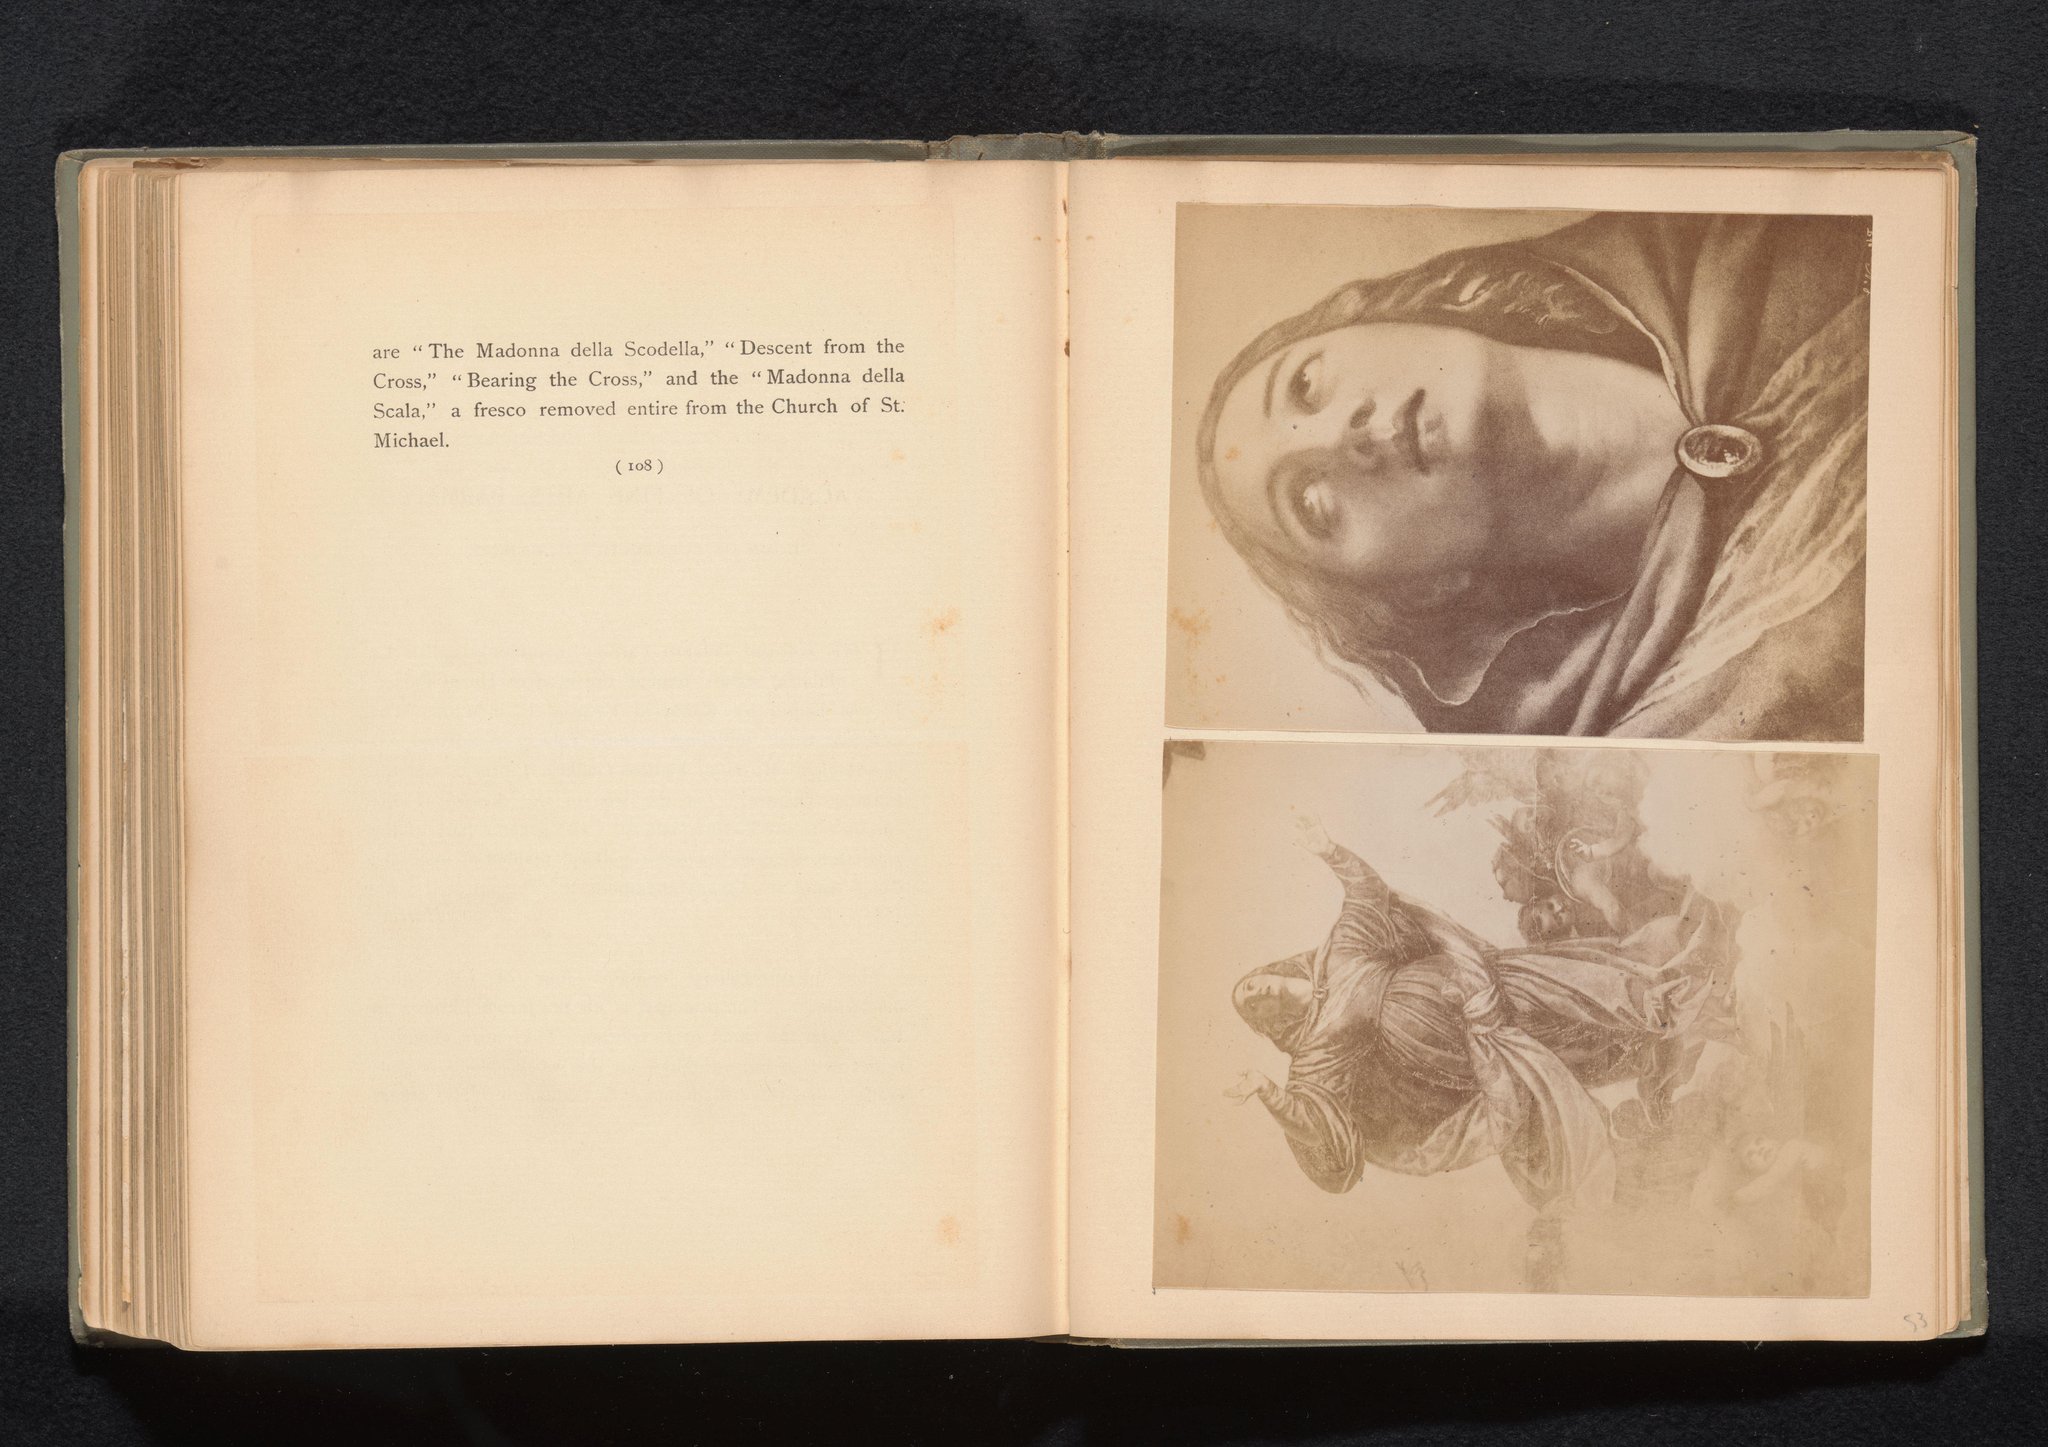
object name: page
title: Twee fotoreproducties van een schilderij, voorstellende de hemelvaart van Maria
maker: Anonymous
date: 1882-1887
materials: photographic support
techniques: albumen print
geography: basilica di santa maria gloriosa dei frari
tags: the assumption of mary ('assumptio corporis'): she is borne into heaven by angels